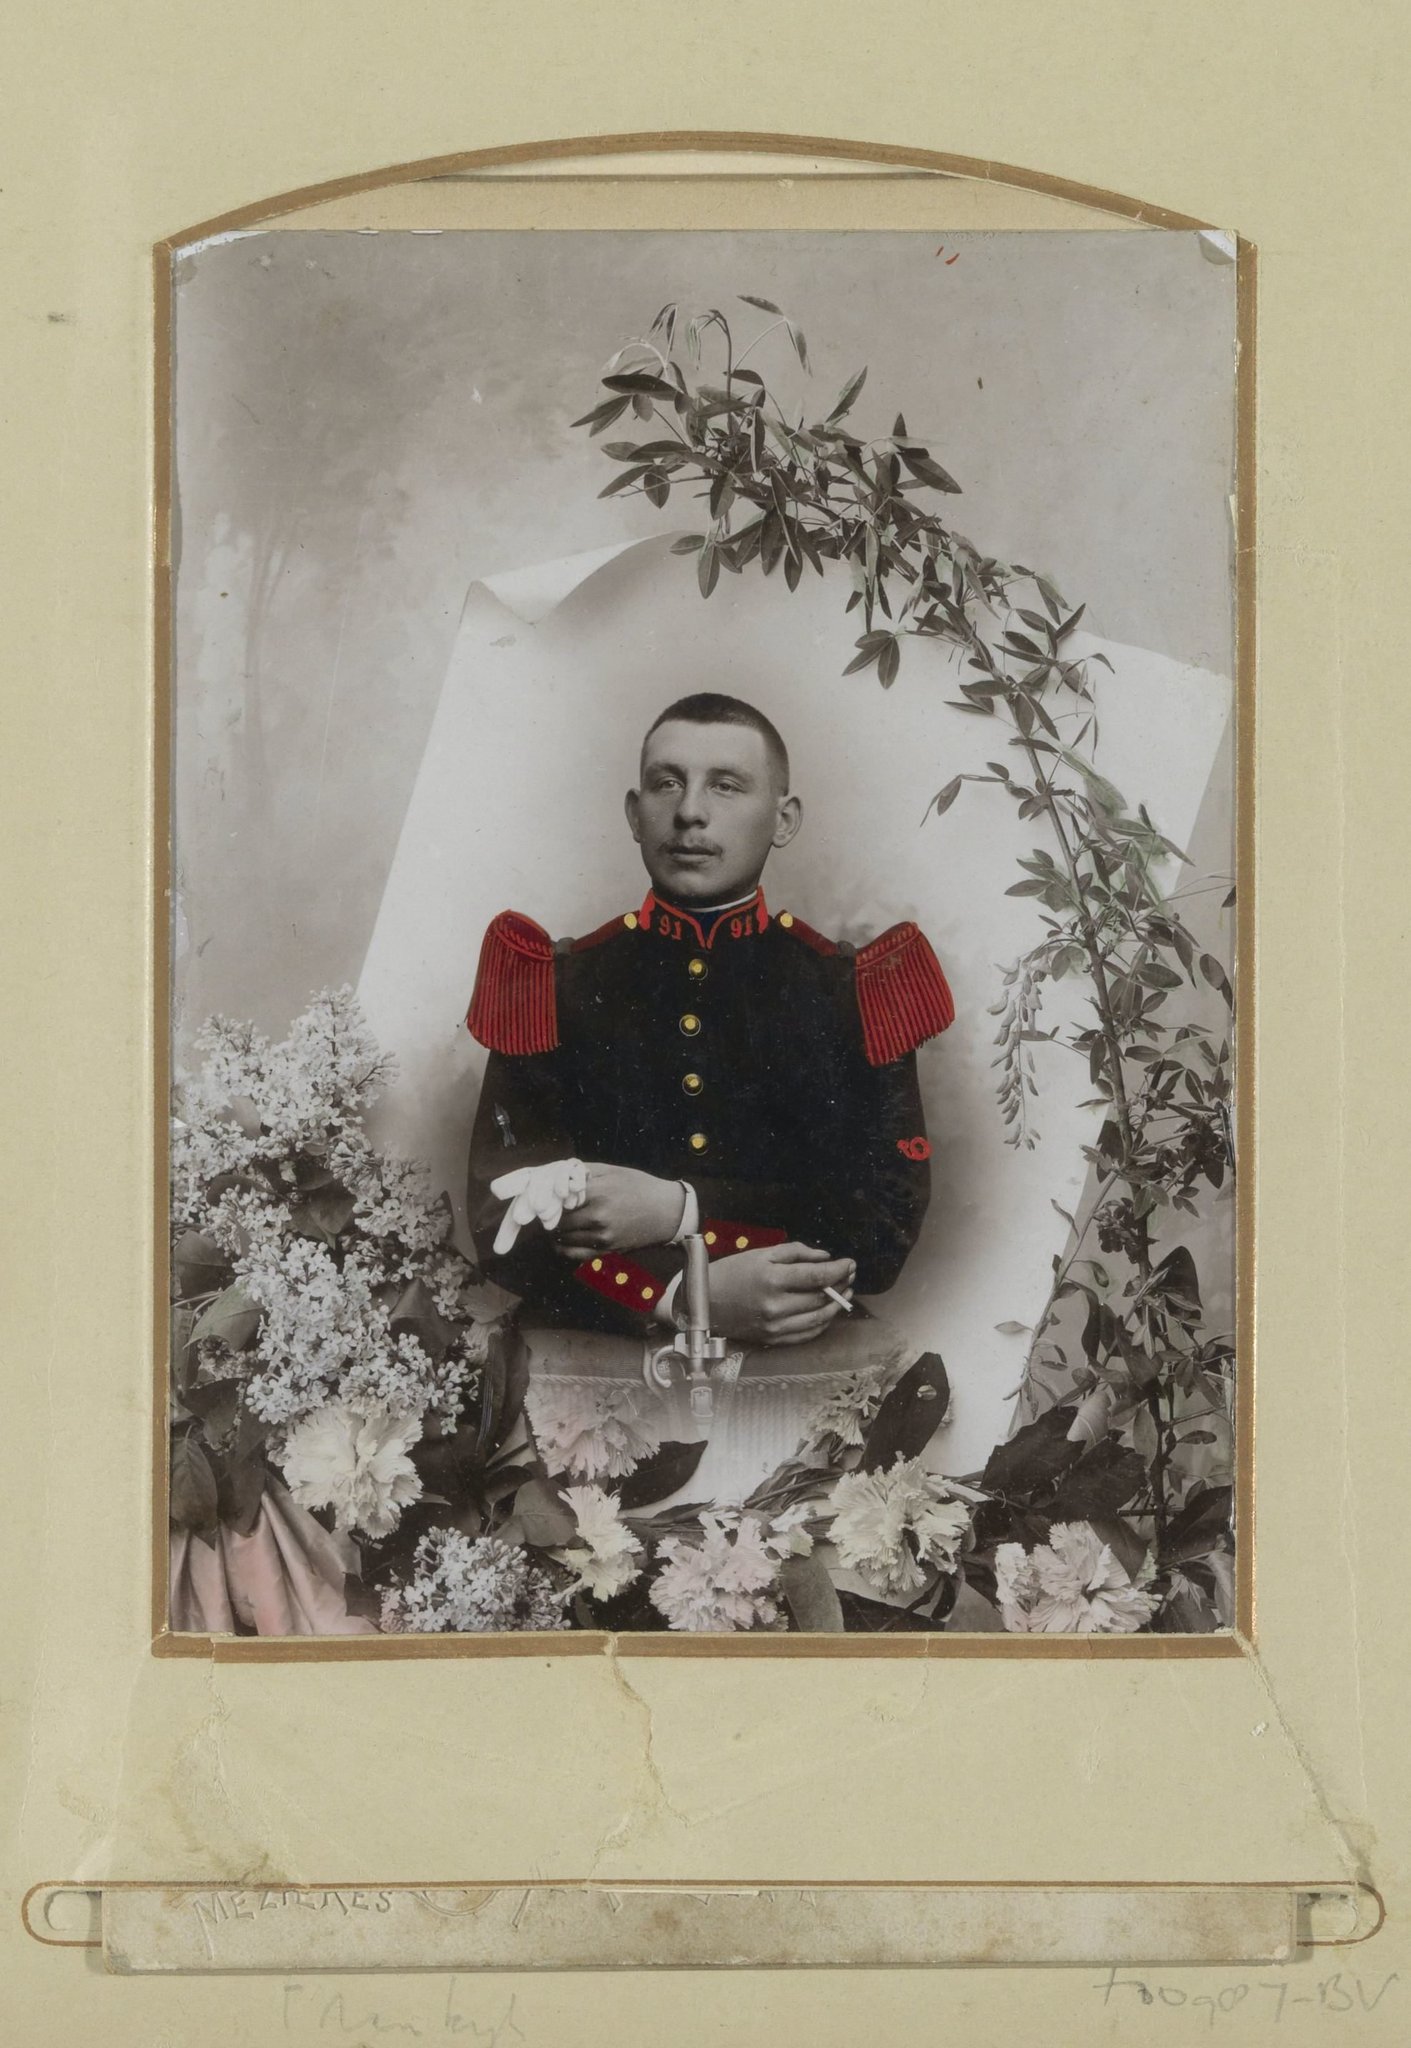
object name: album leaf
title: Portret van een (vermoedelijk) Franse militair, omlijst met bloemen en takken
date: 1885-1900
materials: cardboard, paper, photographic support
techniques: collodion silver print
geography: mézières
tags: warfare; military affairs, (military) uniforms, division of armed forces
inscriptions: inscription: ‘on opère la Nuit à la Lumière Artificielle’, address: ‘Bould. Carnot à Mézières’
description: Onderdeel van Album met cartes-de-visite en kabinetfoto's van militairen in uniform.